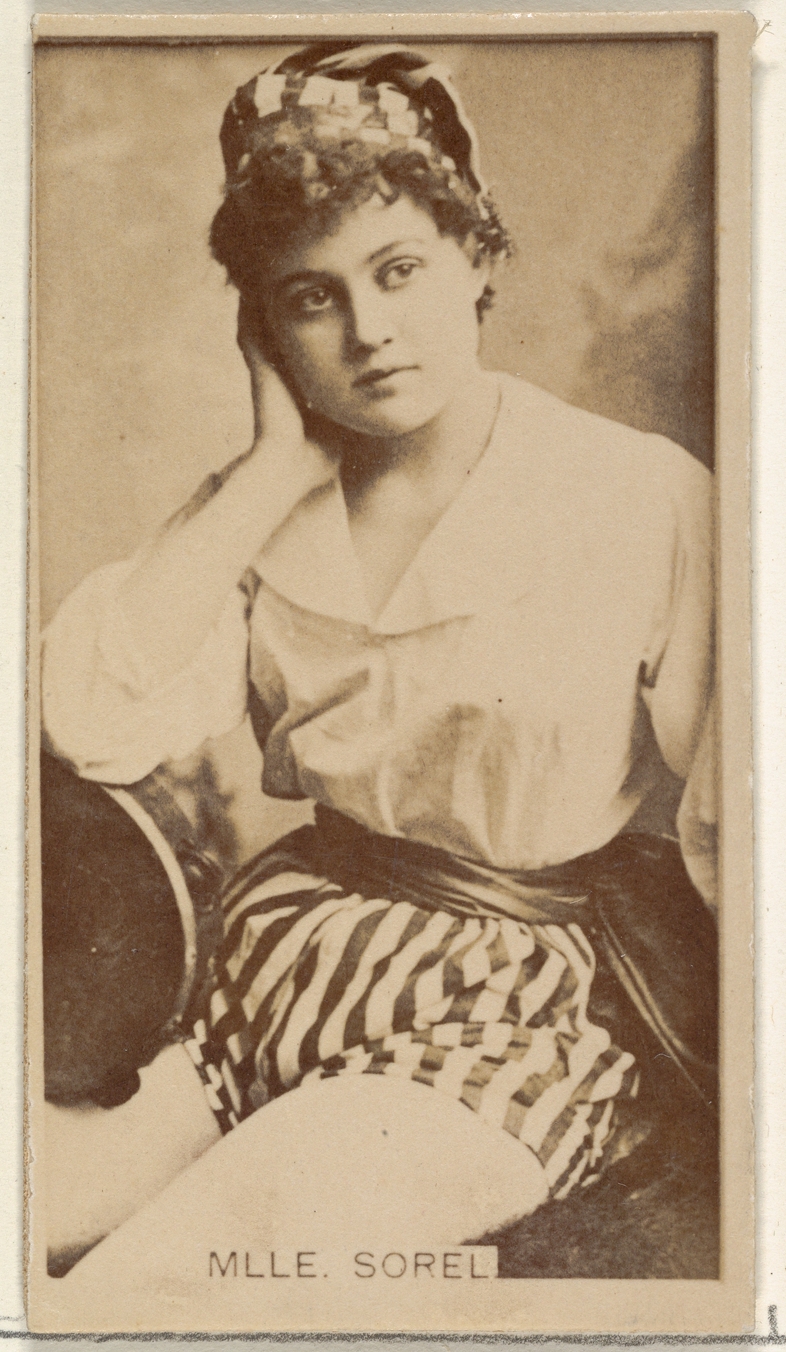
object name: photograph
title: Mlle. Sorel, from the Actors and Actresses series (N45, Type 8) for Virginia Brights Cigarettes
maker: allen & ginter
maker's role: publisher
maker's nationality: american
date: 1888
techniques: albumen silver print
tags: portraits,women,actresses